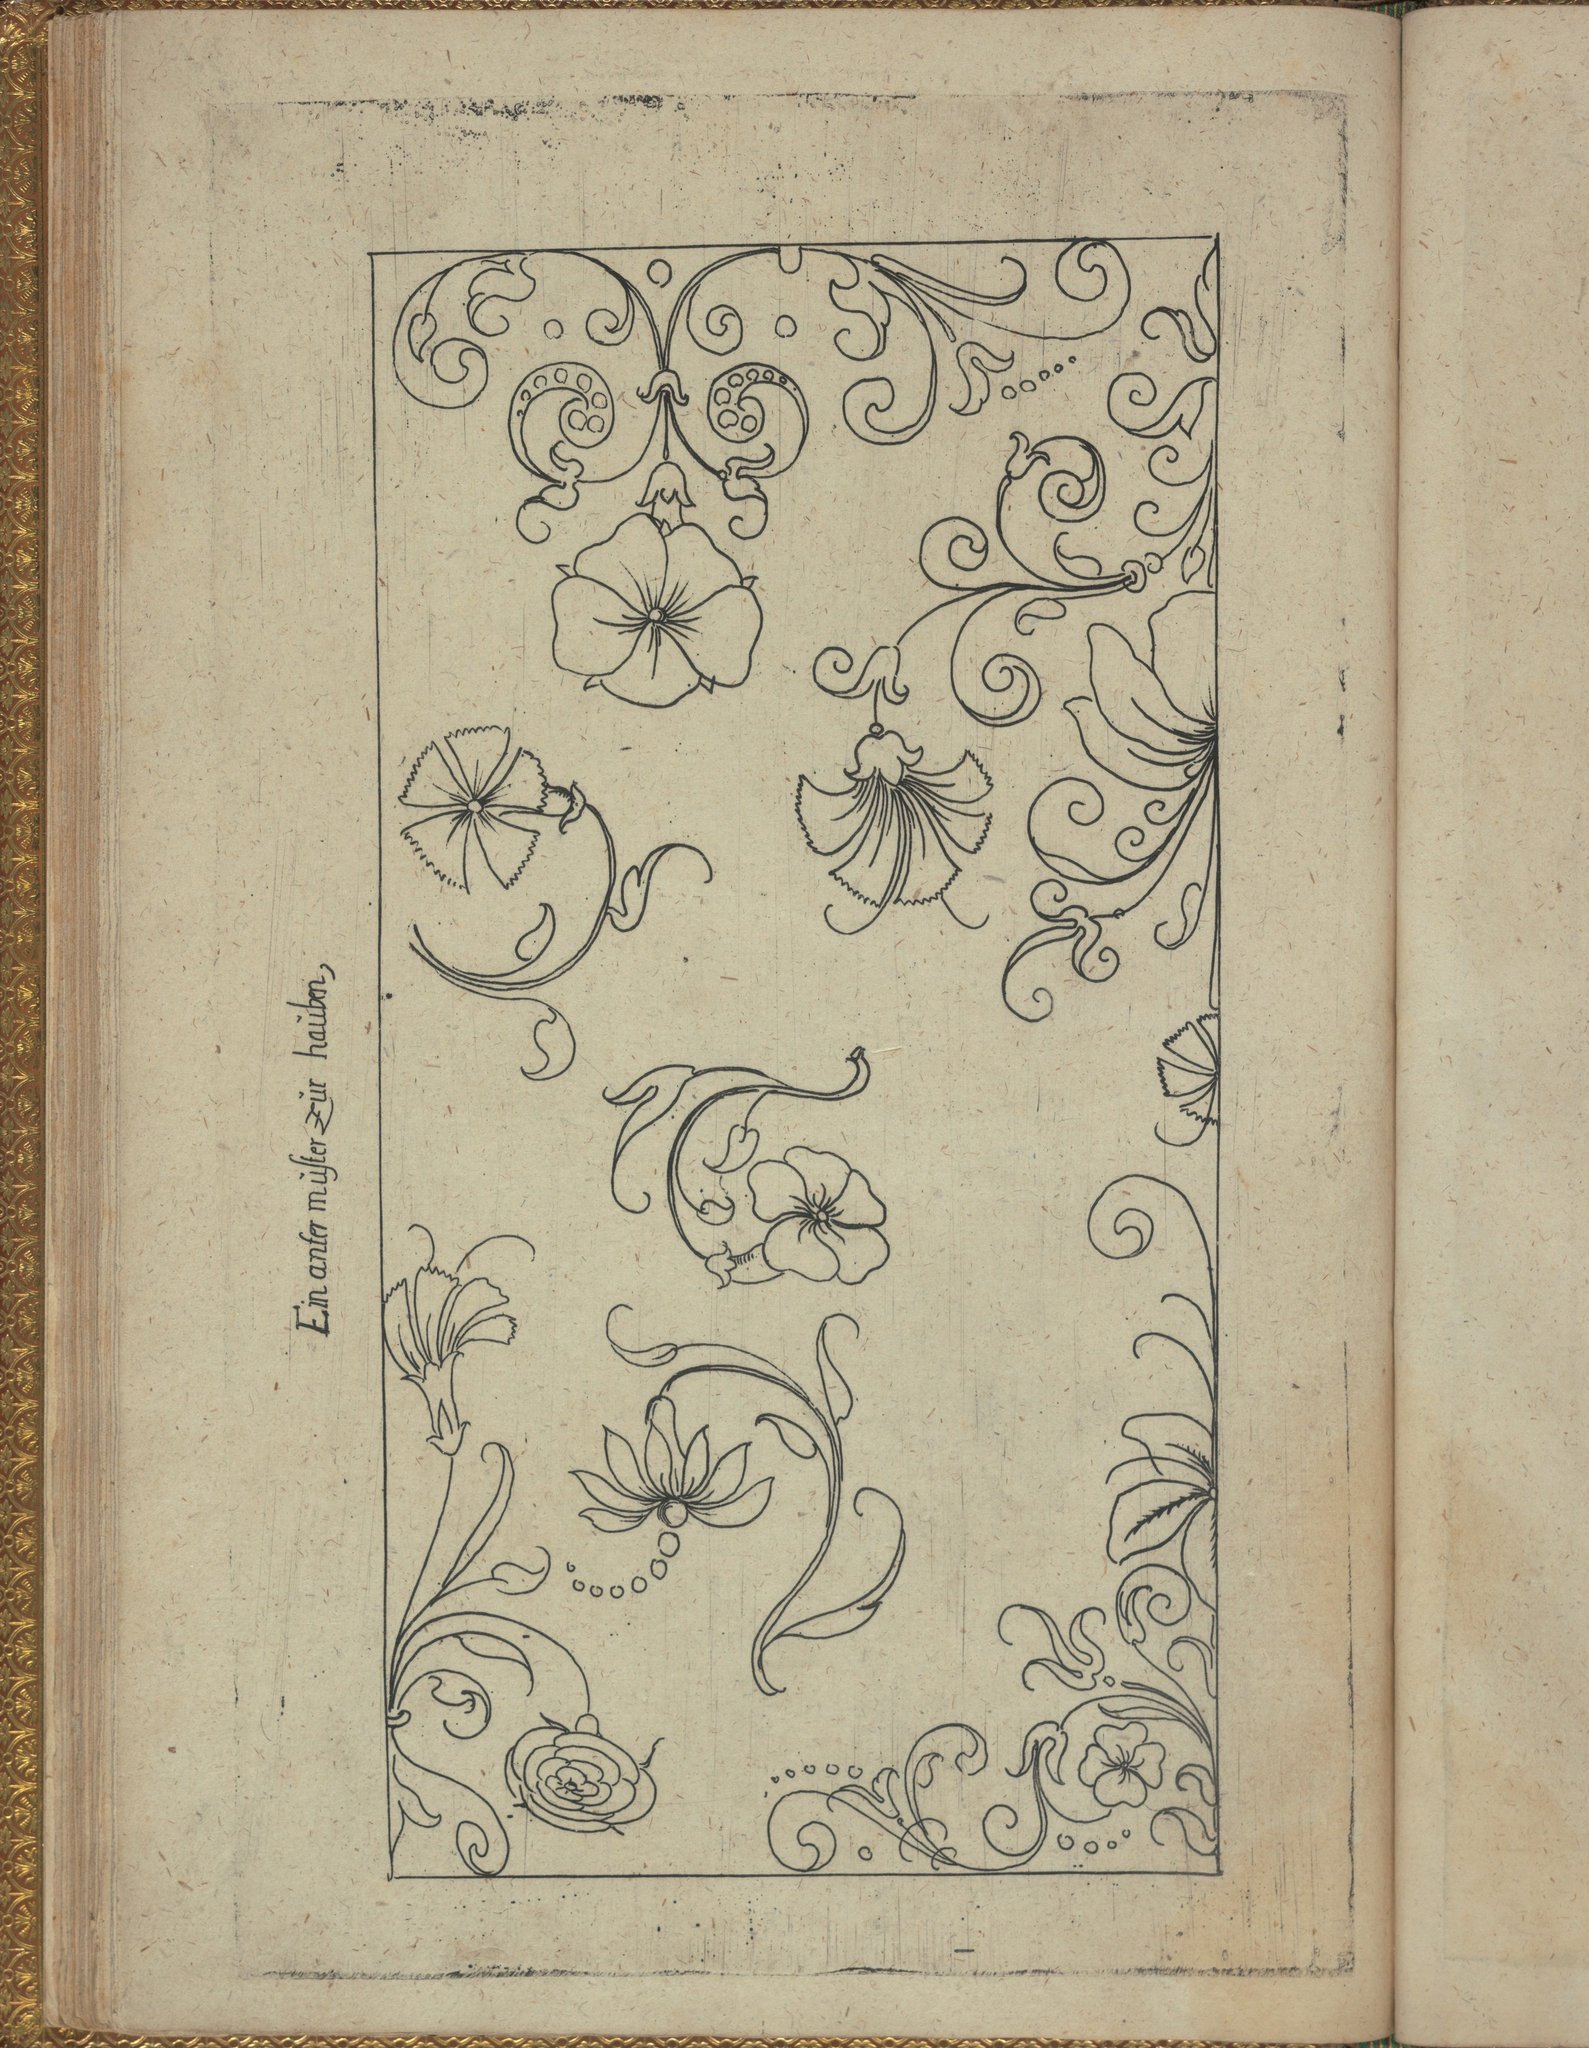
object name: book print ornament architecture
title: New Modelbüch (Page 47v)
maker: andreas bretschneider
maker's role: designer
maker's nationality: german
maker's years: 1573-1645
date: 1615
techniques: etching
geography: germany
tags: flowers